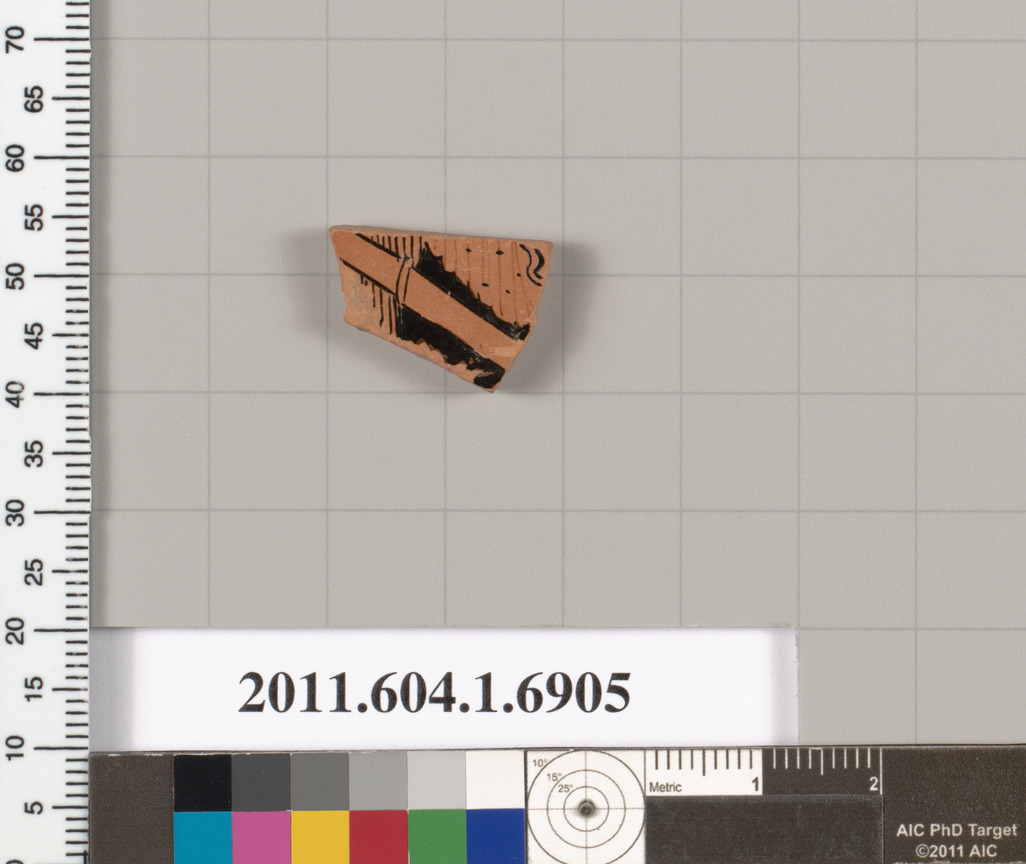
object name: kylix fragment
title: Terracotta fragment of a kylix (drinking cup)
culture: greek, attic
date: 490-470 BCE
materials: terracotta